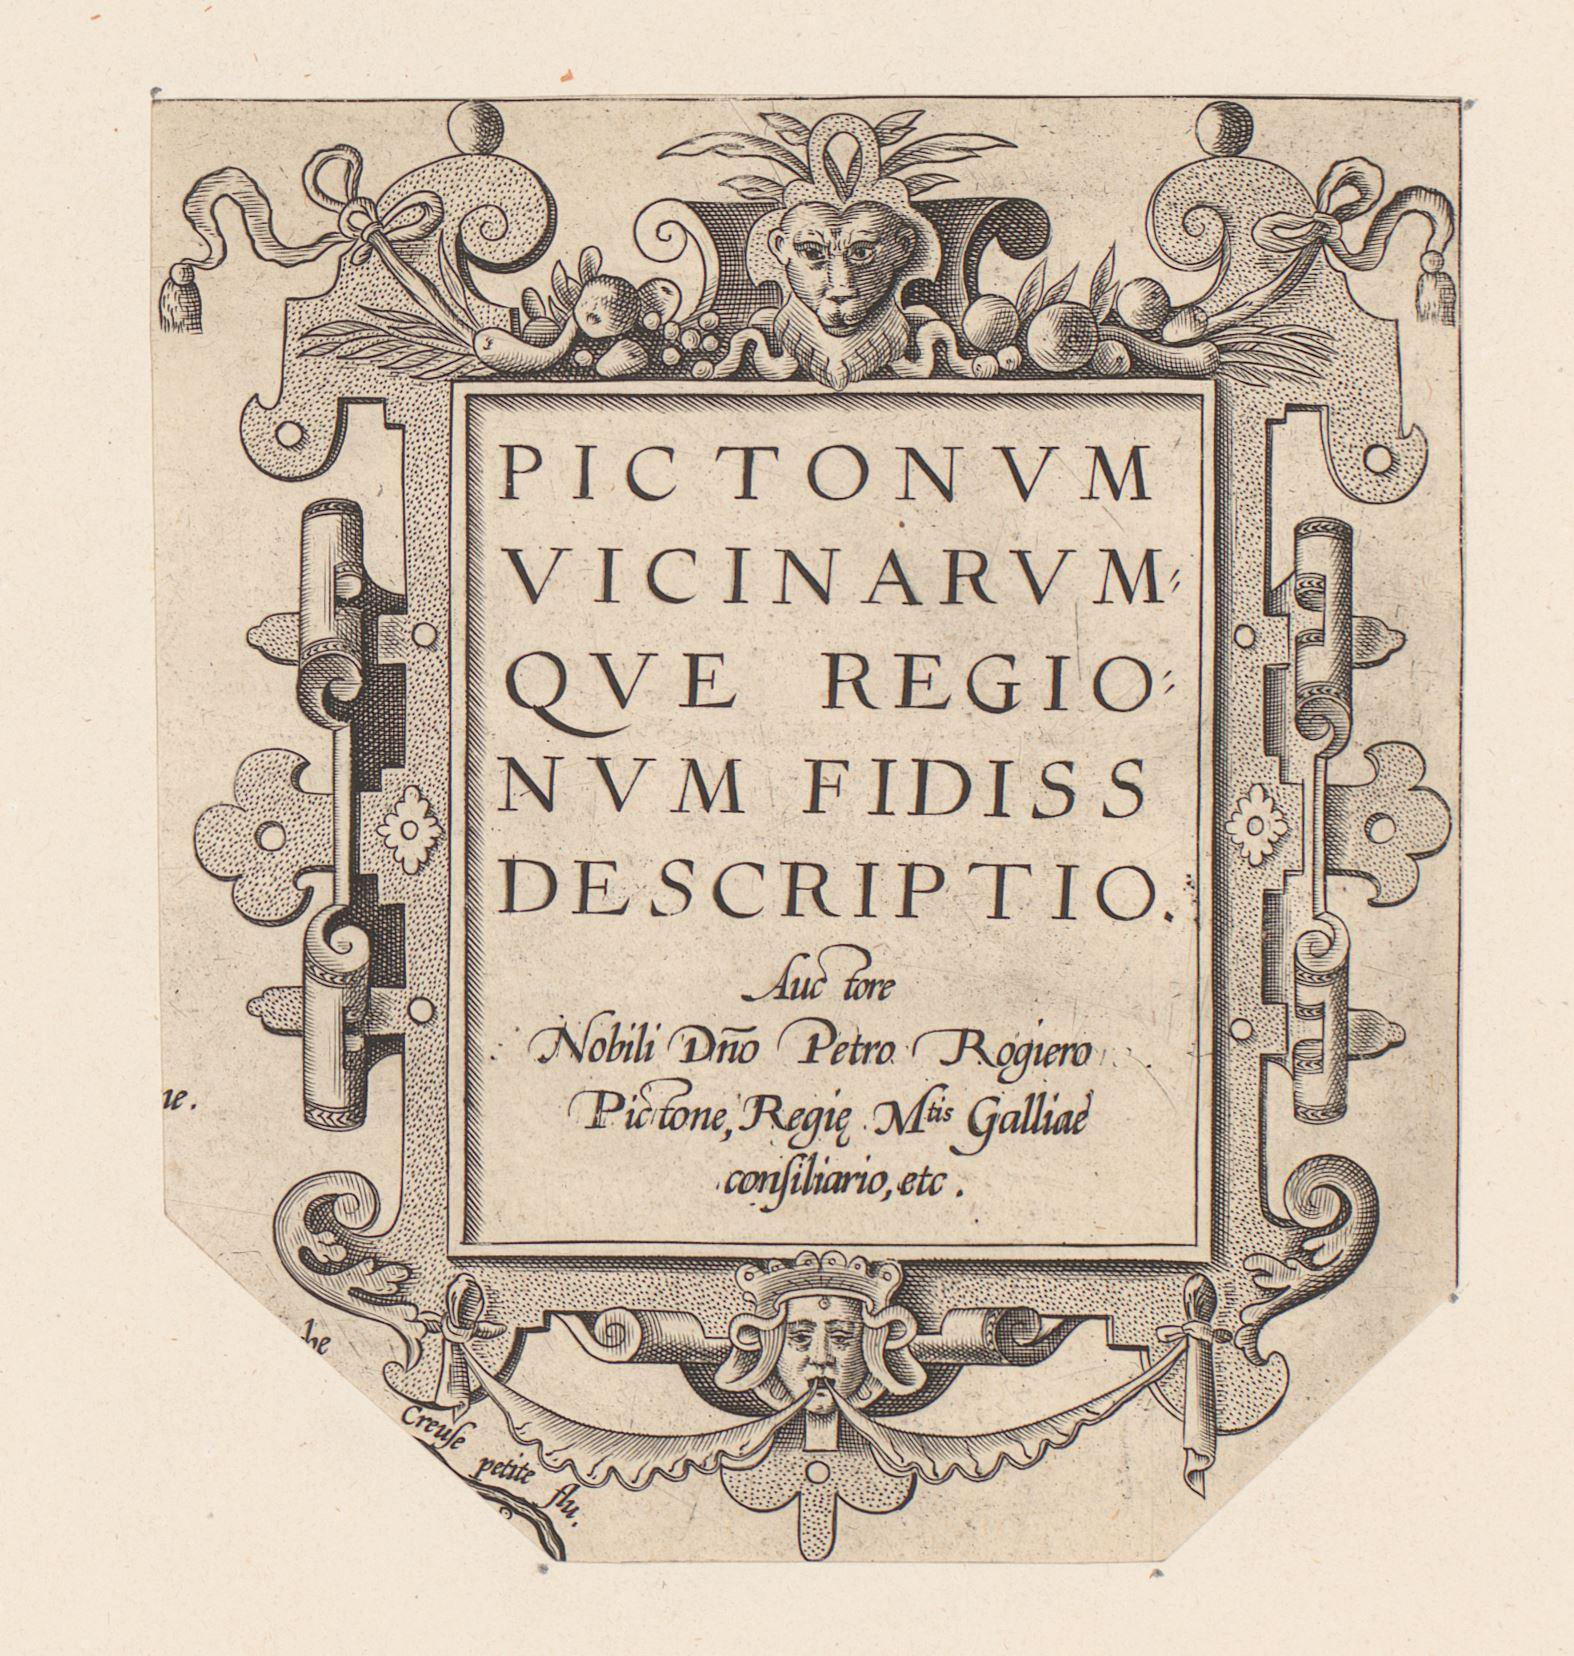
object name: ornament print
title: Theatrum Orbis Terrarum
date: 1579-1580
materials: paper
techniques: engraving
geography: antwerp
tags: ornament ~ cartouche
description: Rechthoekige staande cartouche met midden boven en midden onder een masker. Daarbij de tekst: Pictonum Vicinarum .... De cartouche is een fragment van een kaart van Poitou. De prent maakt deel uit van een album.